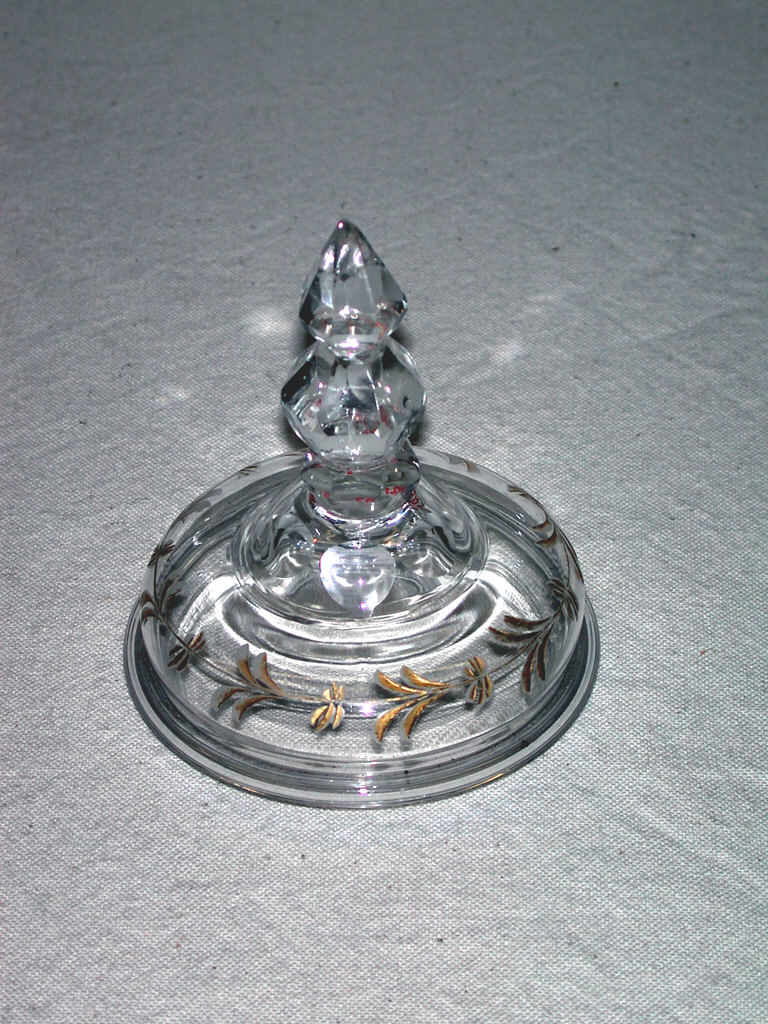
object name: cover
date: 1701-1800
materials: gilt, glass